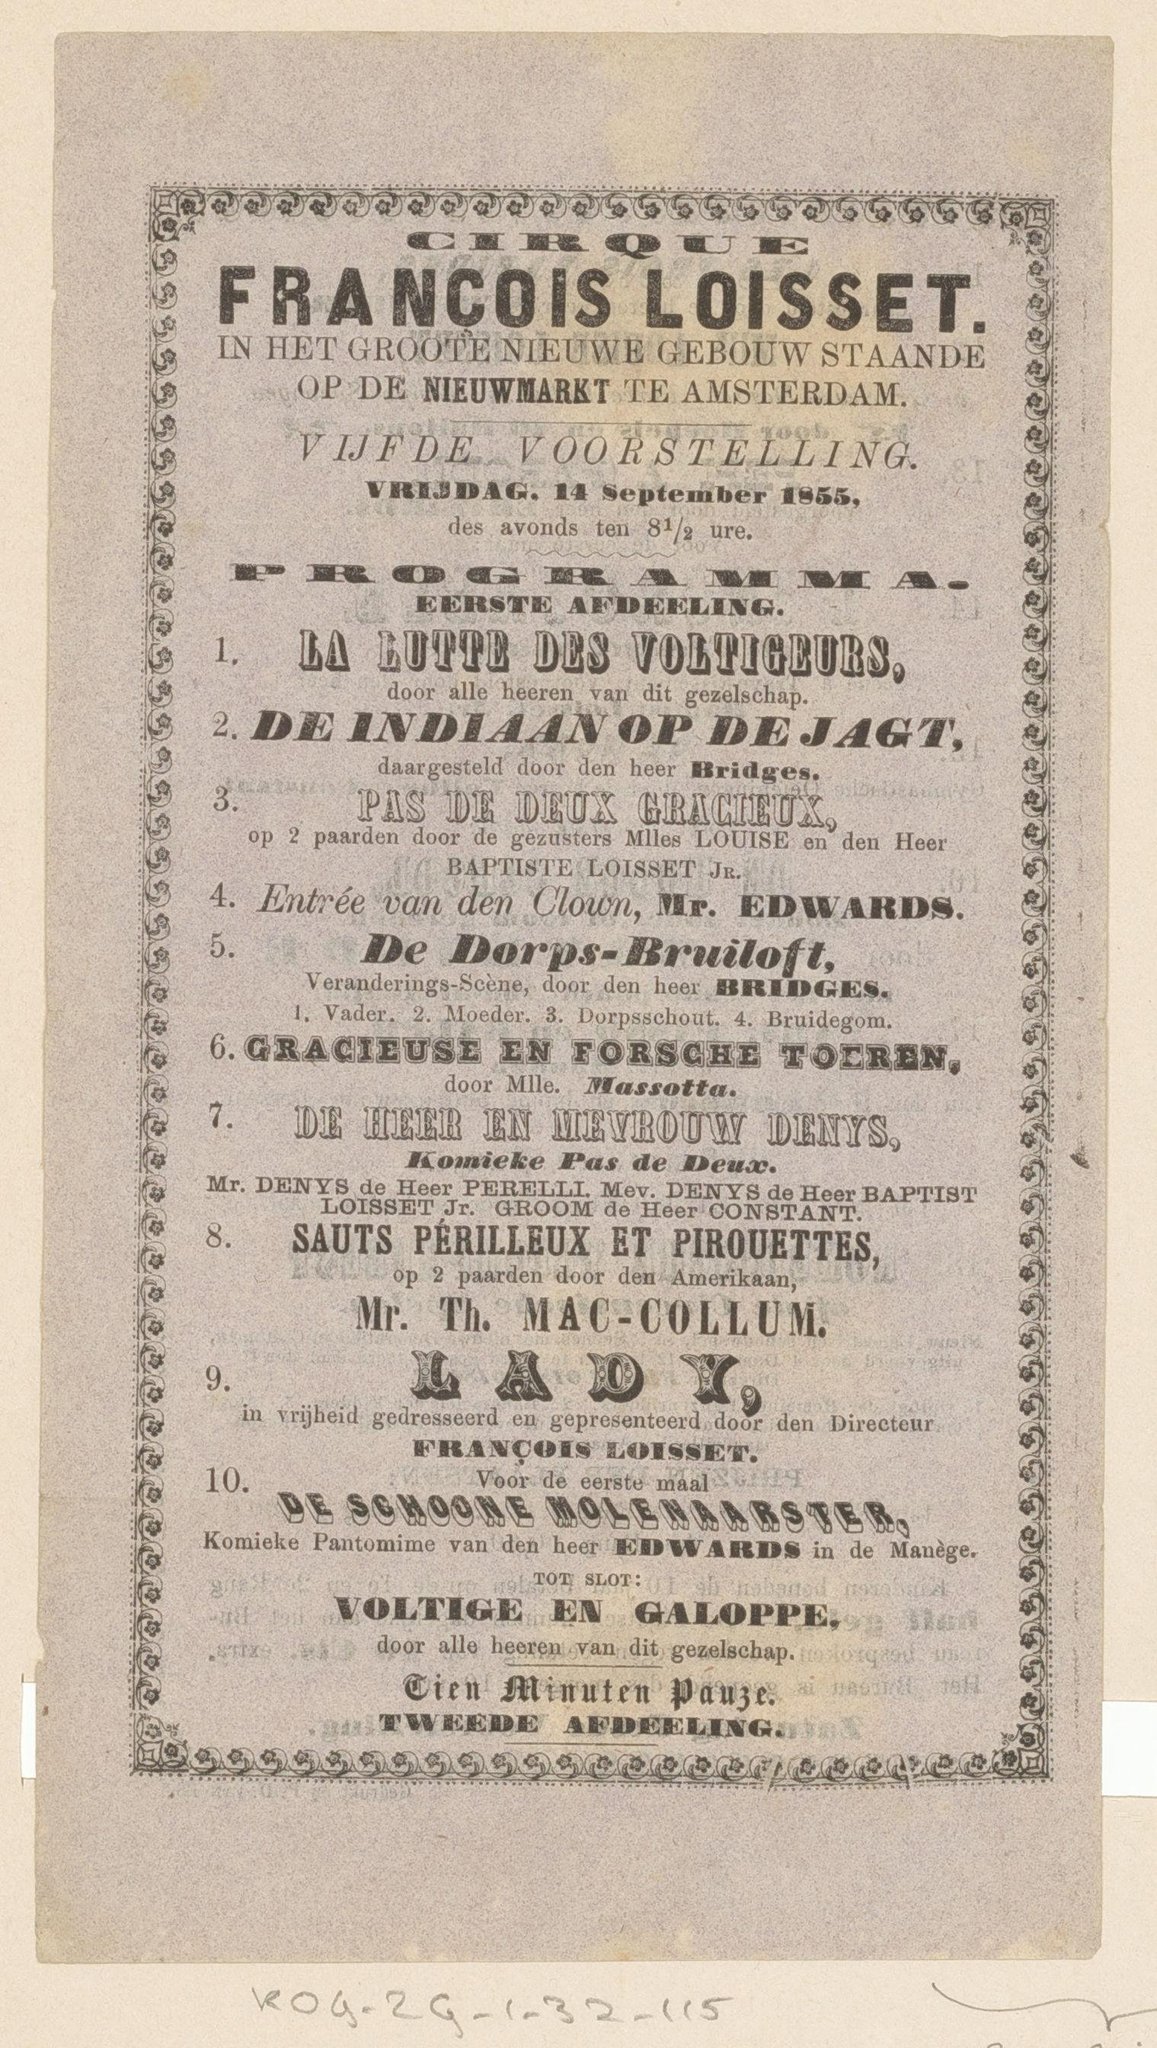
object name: text sheet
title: Cirque François Loisset. In het groote nieuwe gebouw staande op de Nieuwmarkt te Amsterdam. Vijfde voorstelling. Vrijdag. 14 september 1855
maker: pieter dingeman van es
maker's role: boekdrukker, steendrukker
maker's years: 1826-1873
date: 1855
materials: paper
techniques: letterpress printing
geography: amsterdam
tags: circus animals, pleasure fair and circus, horses (circus performance), amsterdam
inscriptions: collector's mark: Lugt 1641, collector's mark